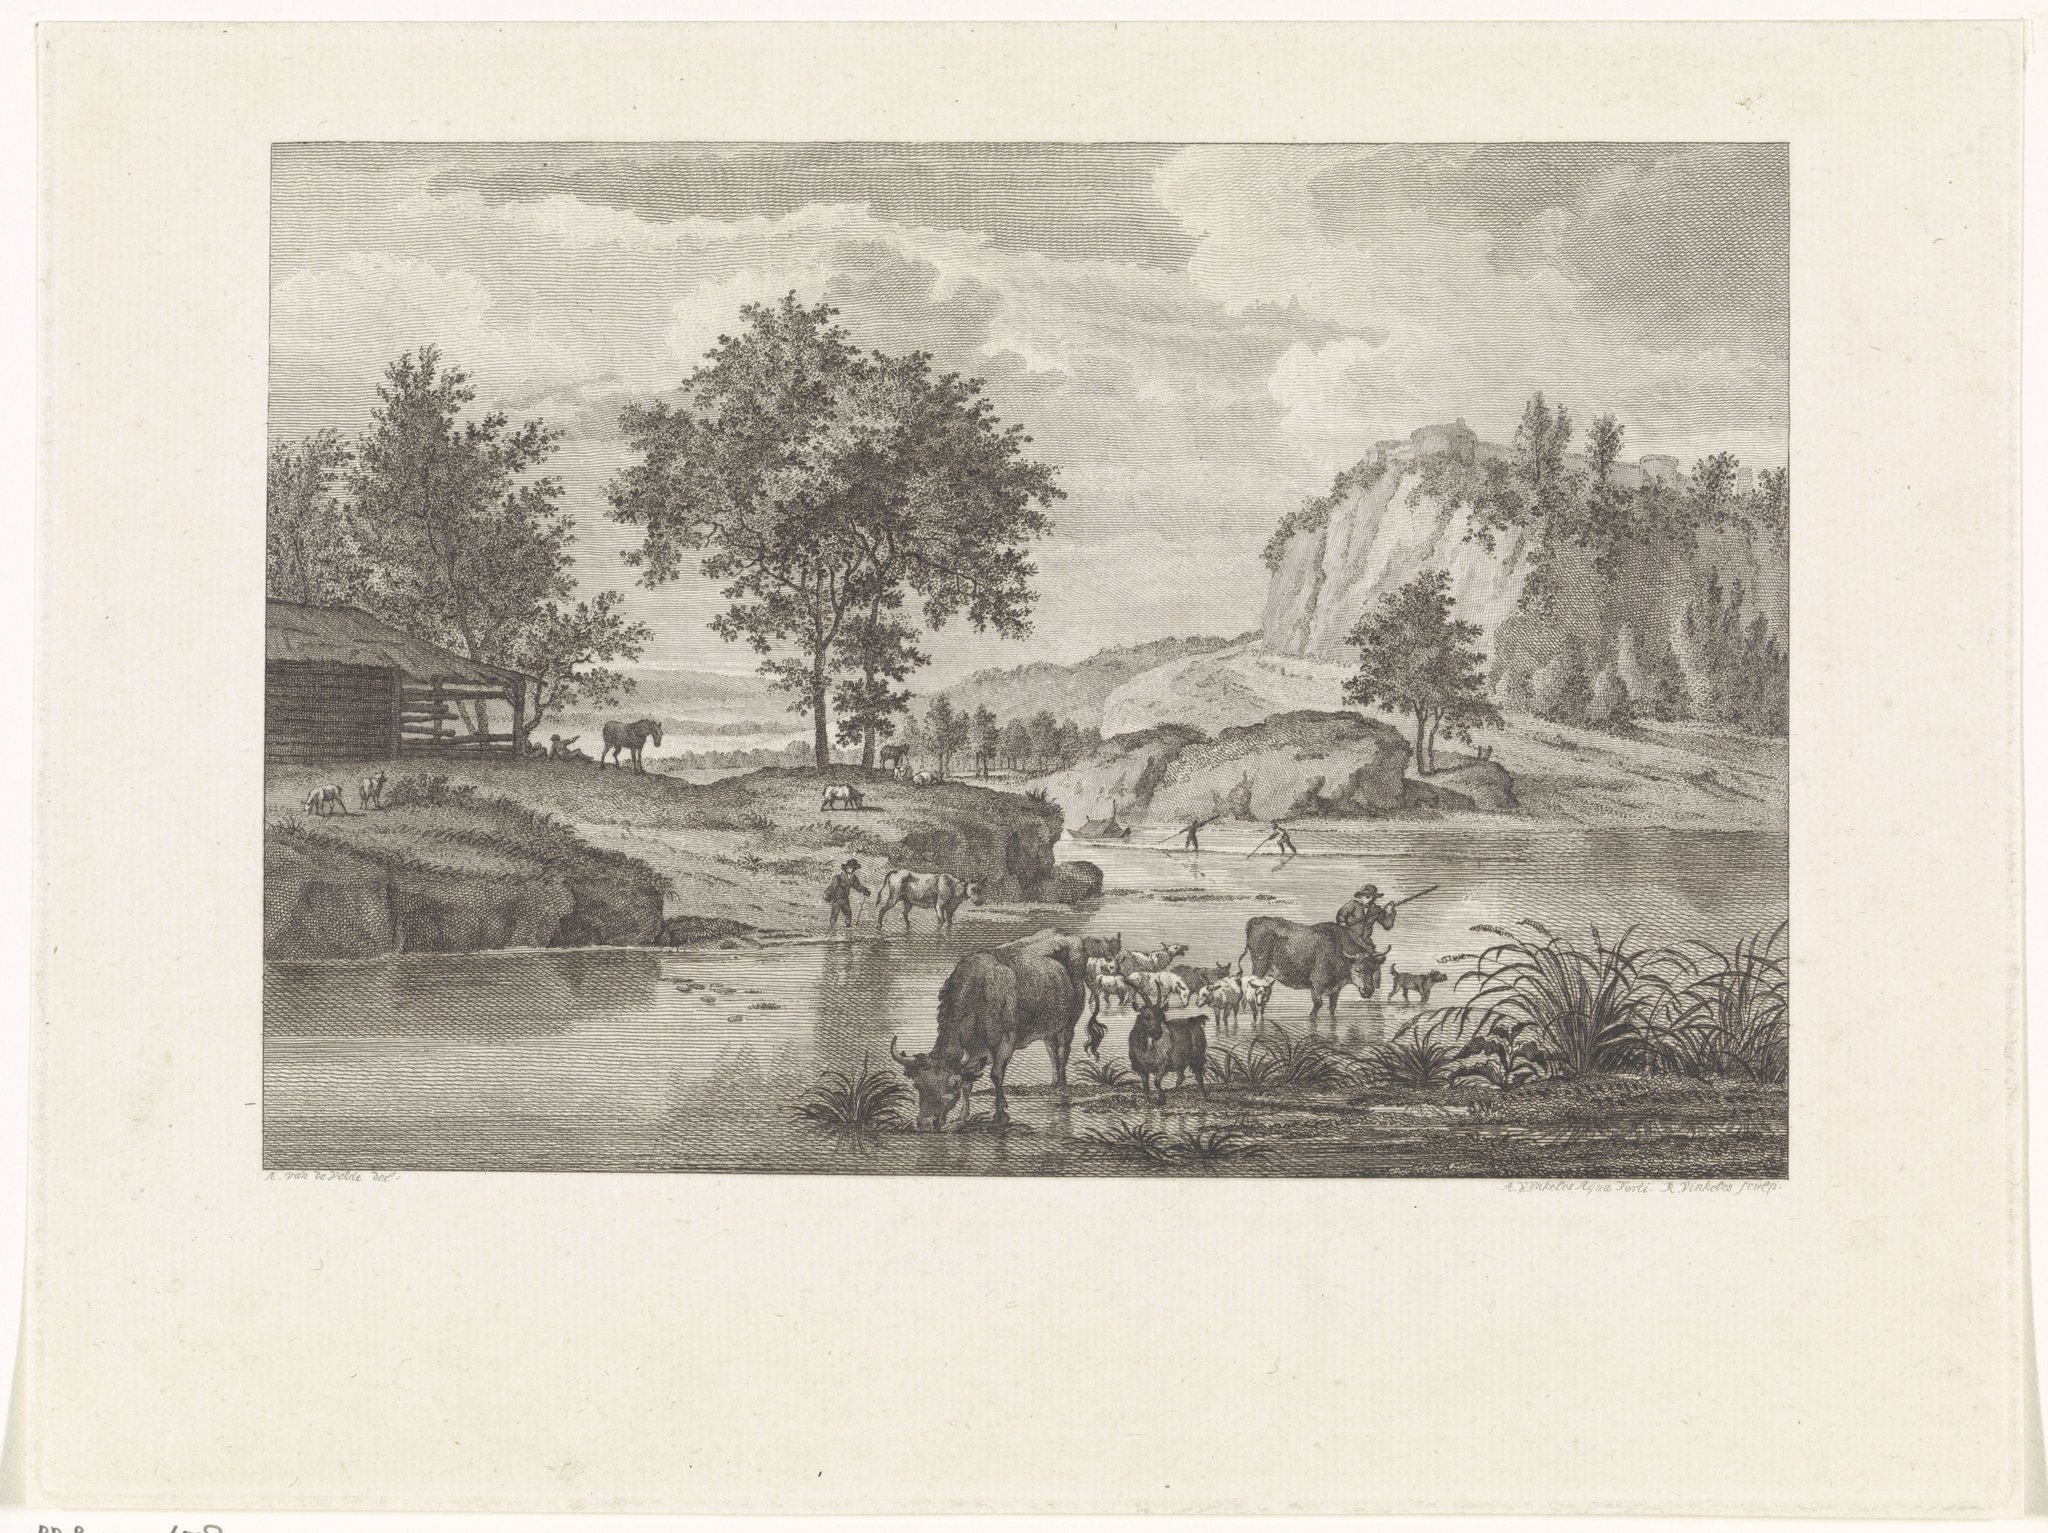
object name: print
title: Herders met vee bij een doorwaardbare plaats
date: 1800-1864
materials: paper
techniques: engraving, etching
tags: crossing a river, ford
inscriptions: collector's mark: Lugt 2228